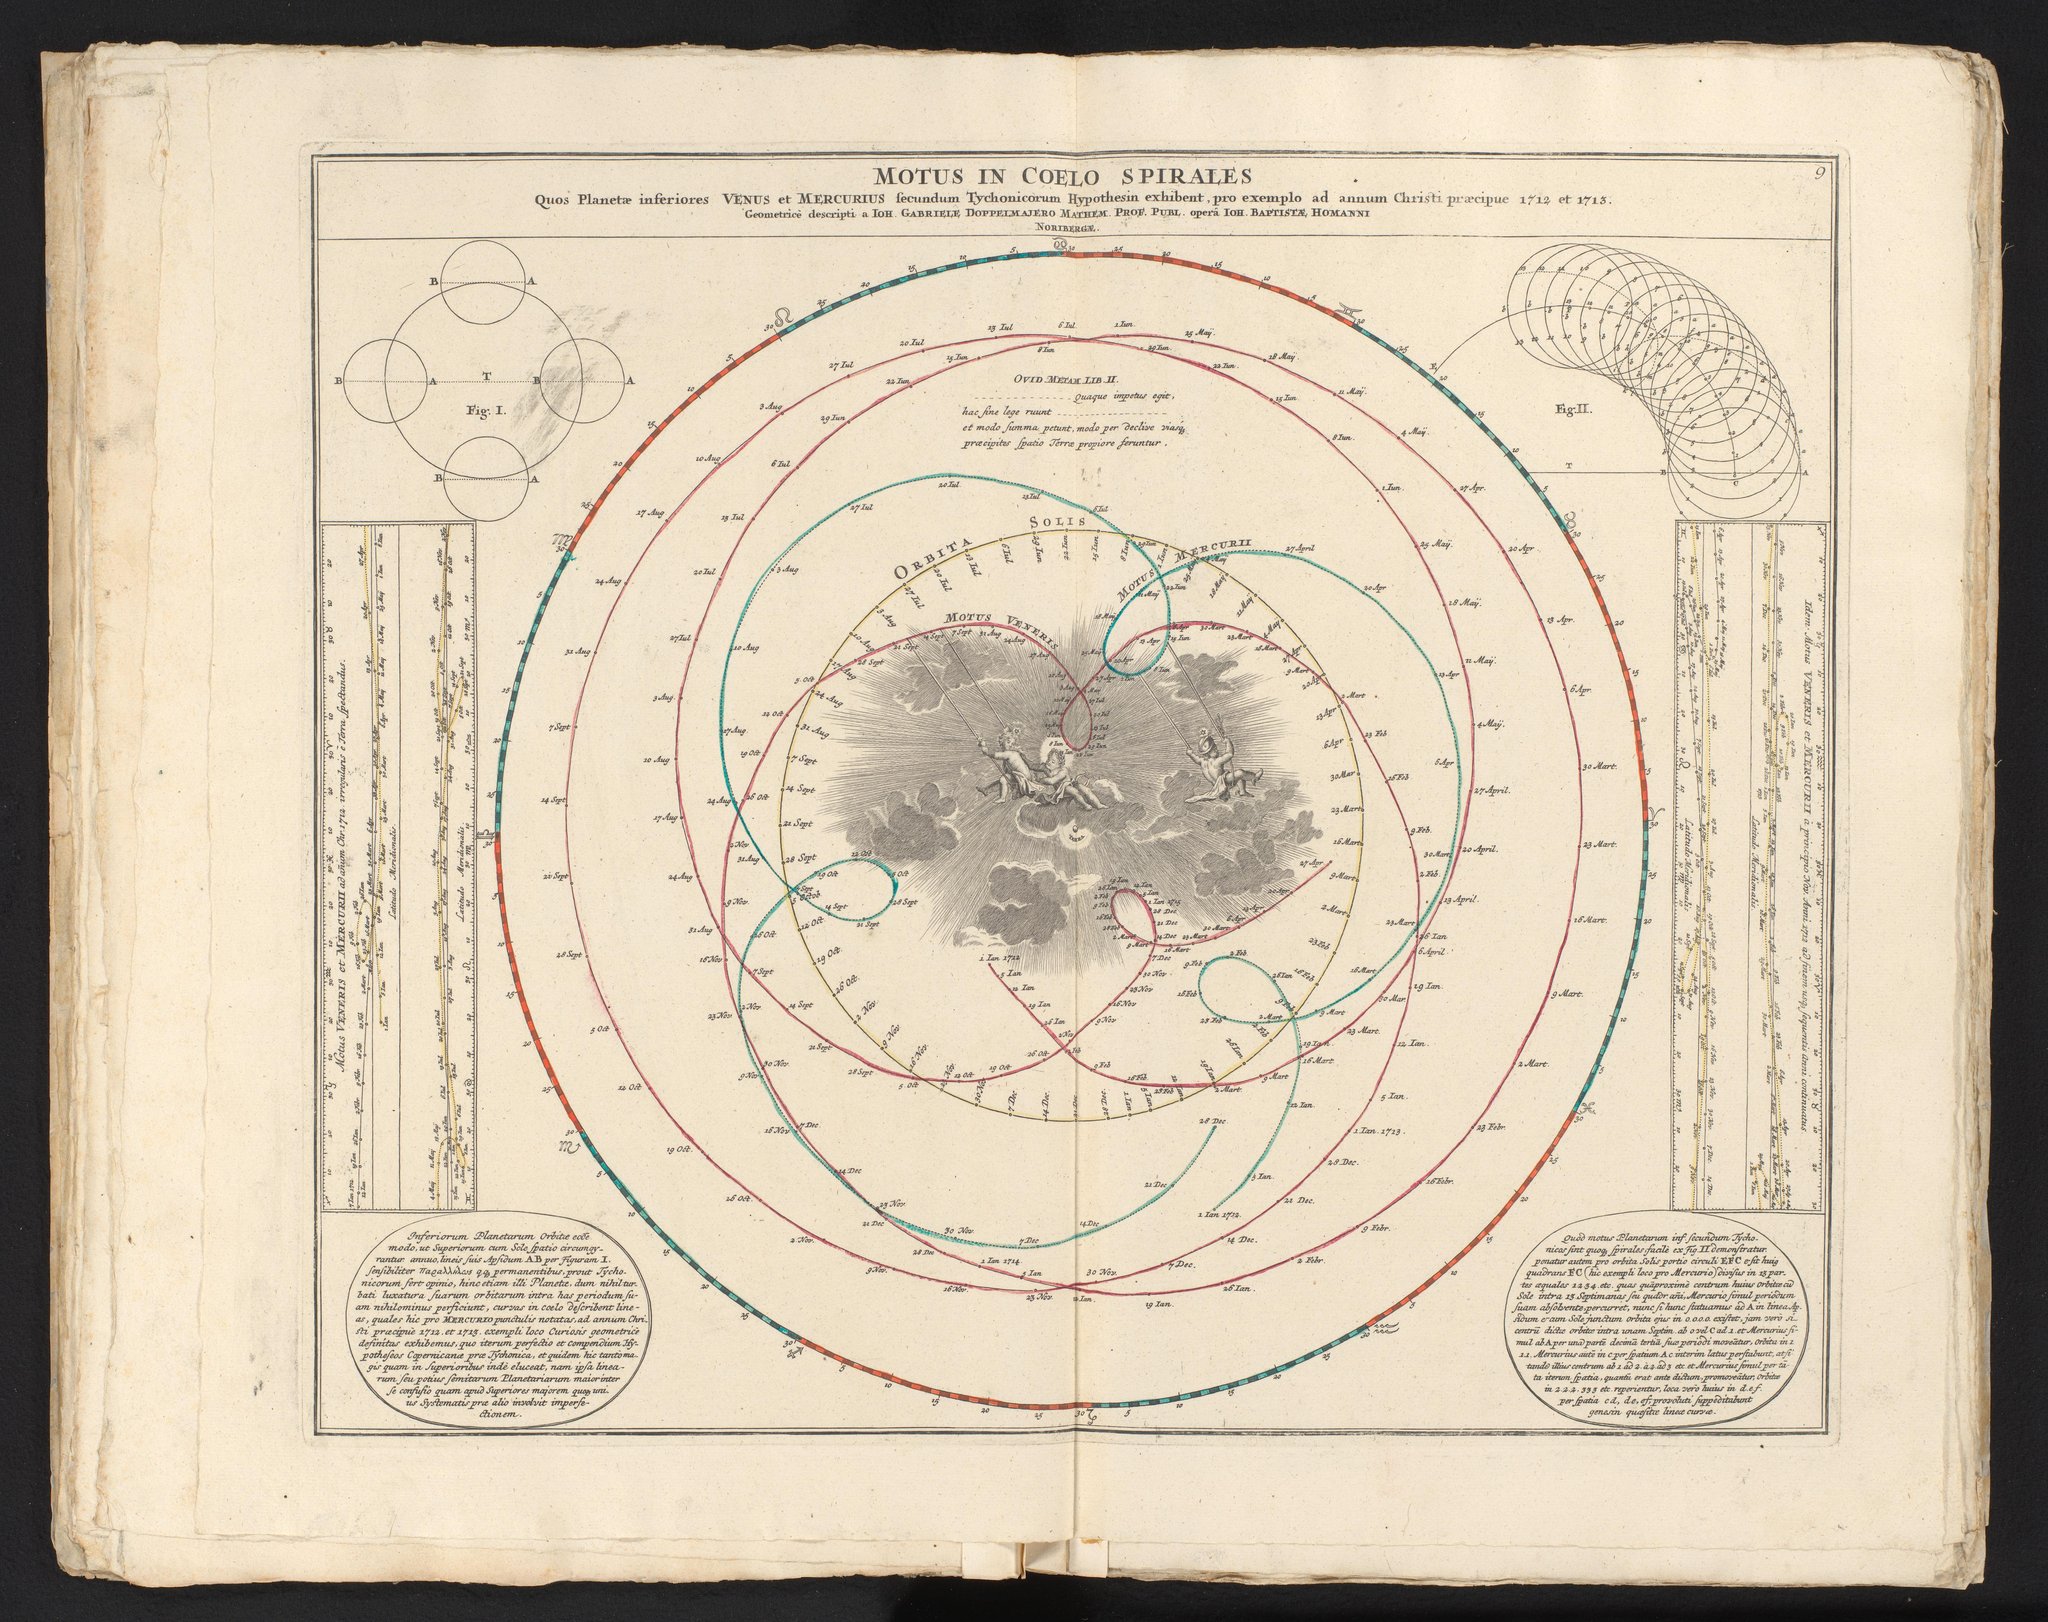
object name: print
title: Hemelkaart met de banen van Venus en Mercurius, volgens Brahe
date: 1742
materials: paper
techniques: engraving, etching, hand coloring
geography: nuremberg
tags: swing, venus (planet), mercury (planet), star-chart, star map